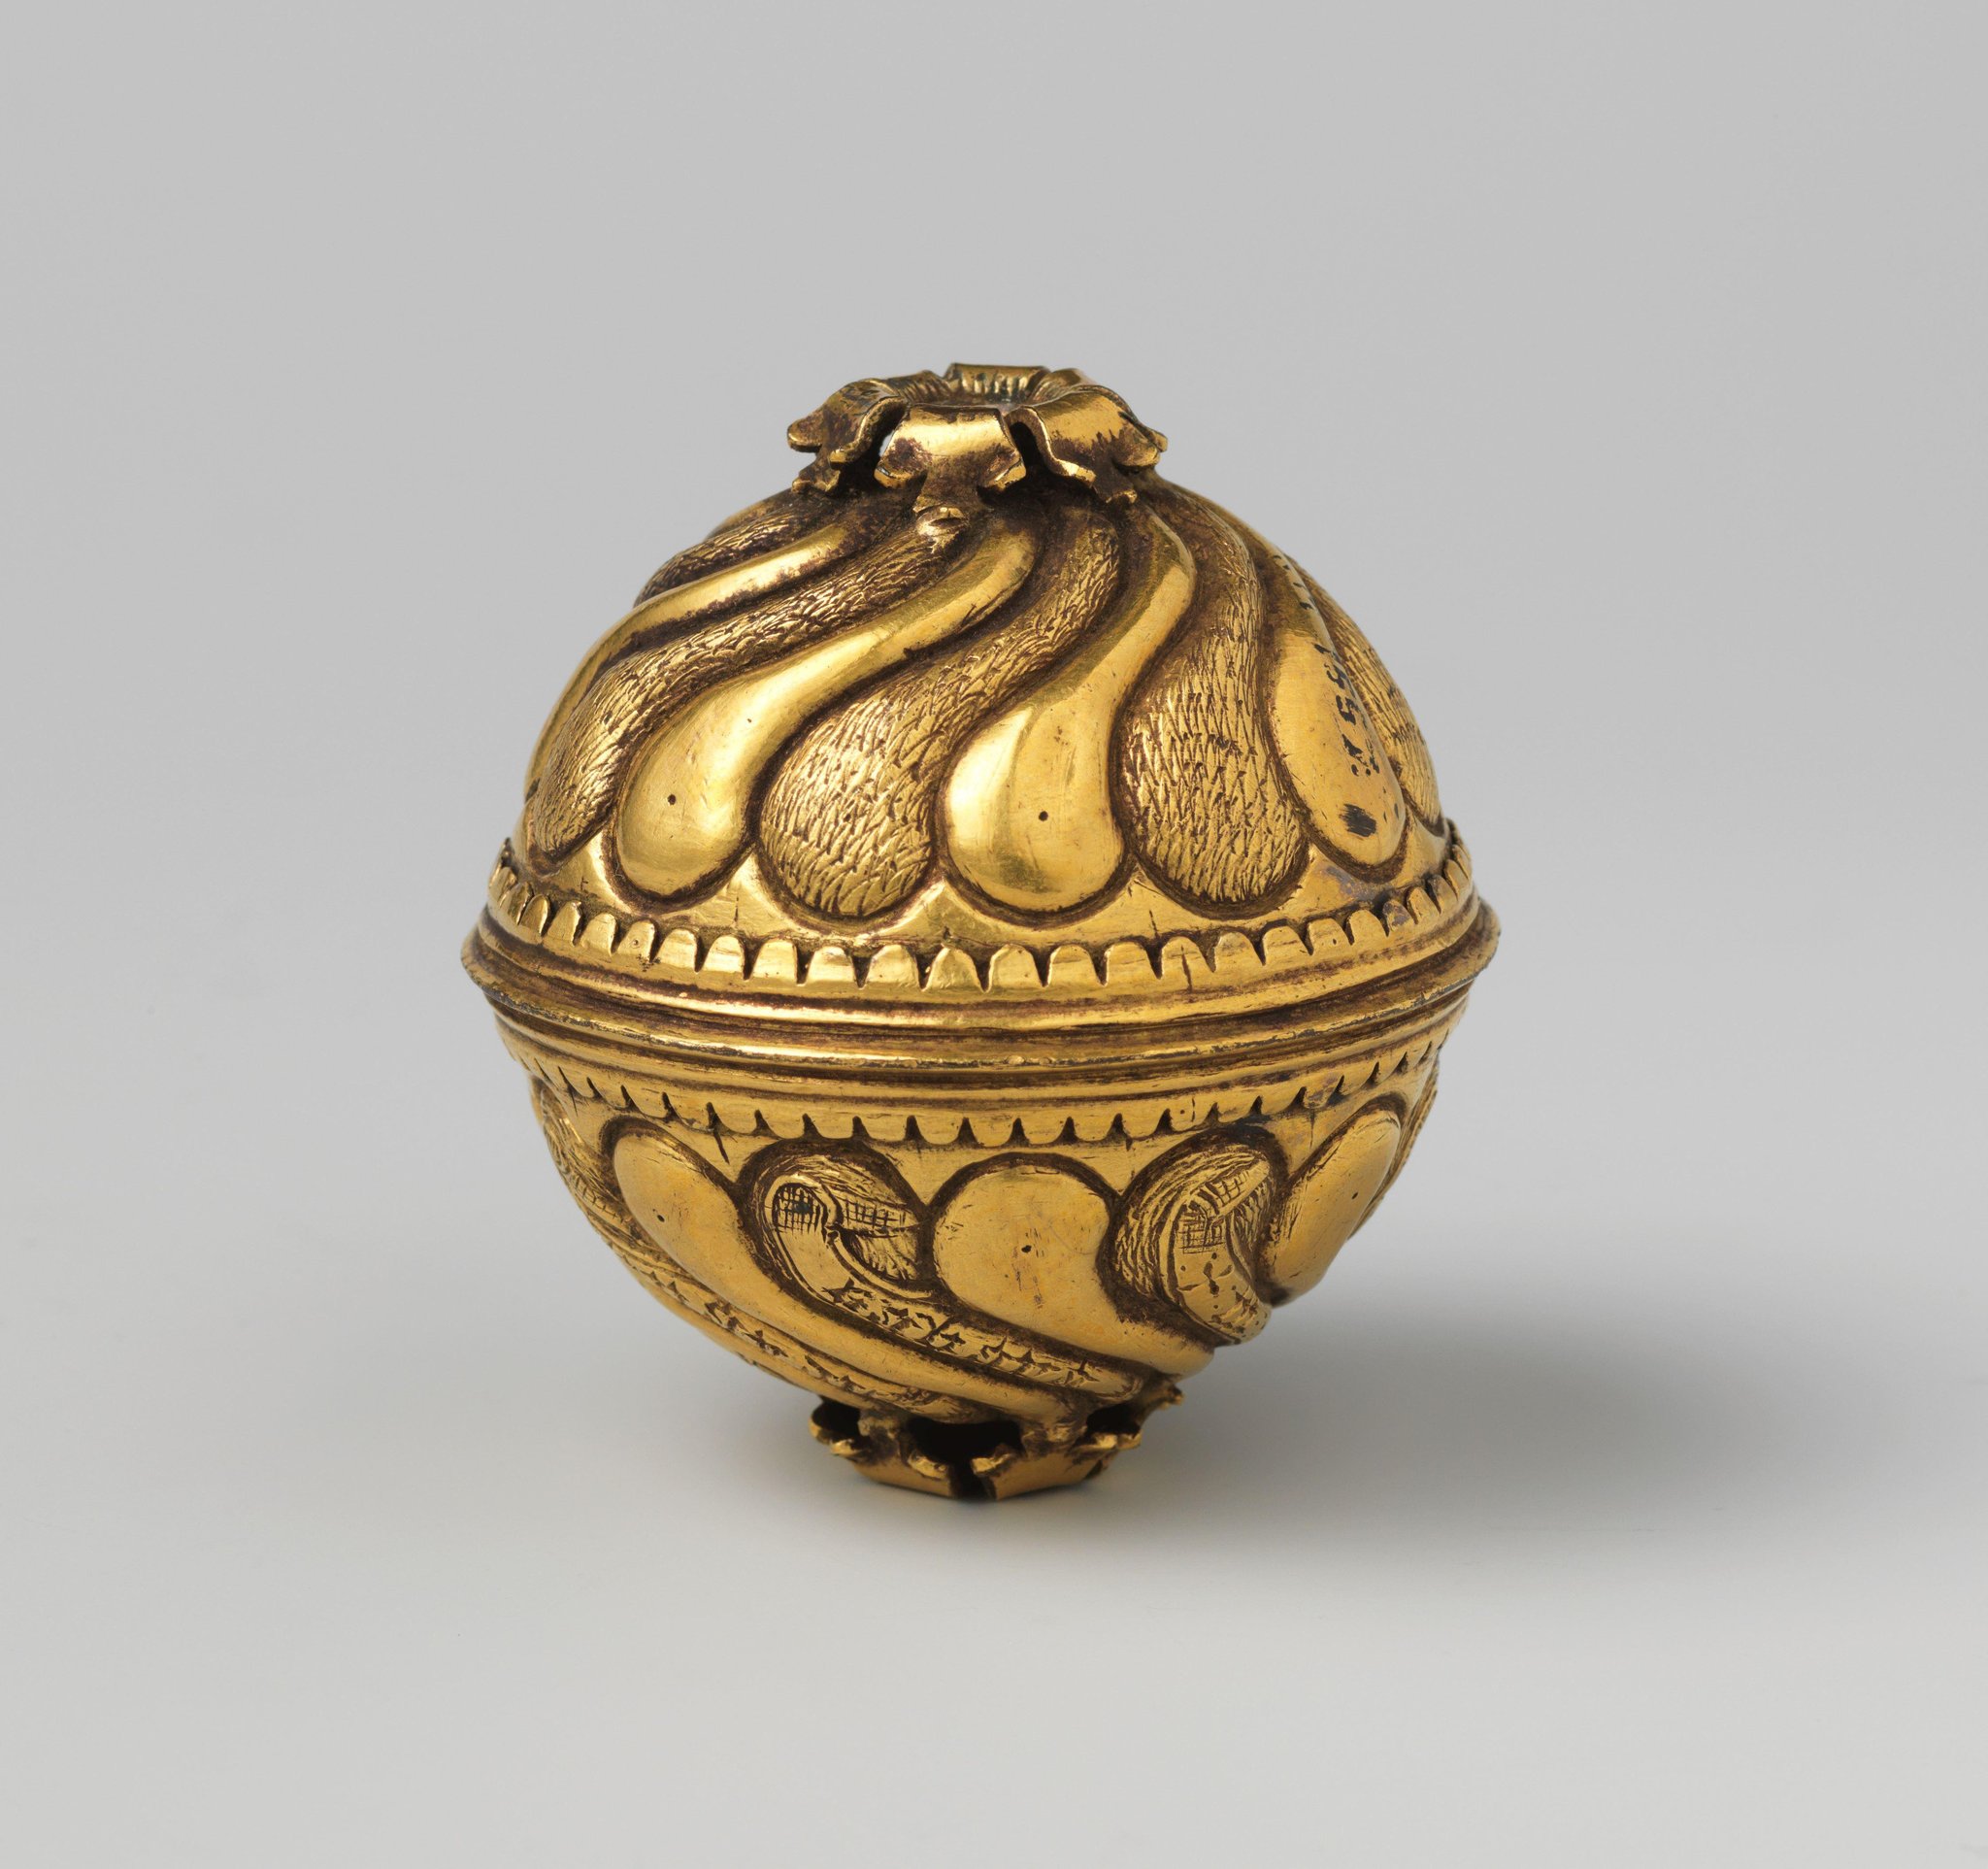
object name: pomellum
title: Pommellum versierd met visblazen en banderollen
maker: Anonymous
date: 1450-1500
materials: copper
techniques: gilding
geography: germany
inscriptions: inscription: ‘+ m + . + m +’, inscription: ‘petrus + kattarina’, inscription: ‘+ maria +’, inscription: ‘barbara’, inscription: ‘jhesus +’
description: Pommel (decorative ball for a cope). Copper. Germany, c. 1450 - 1500.